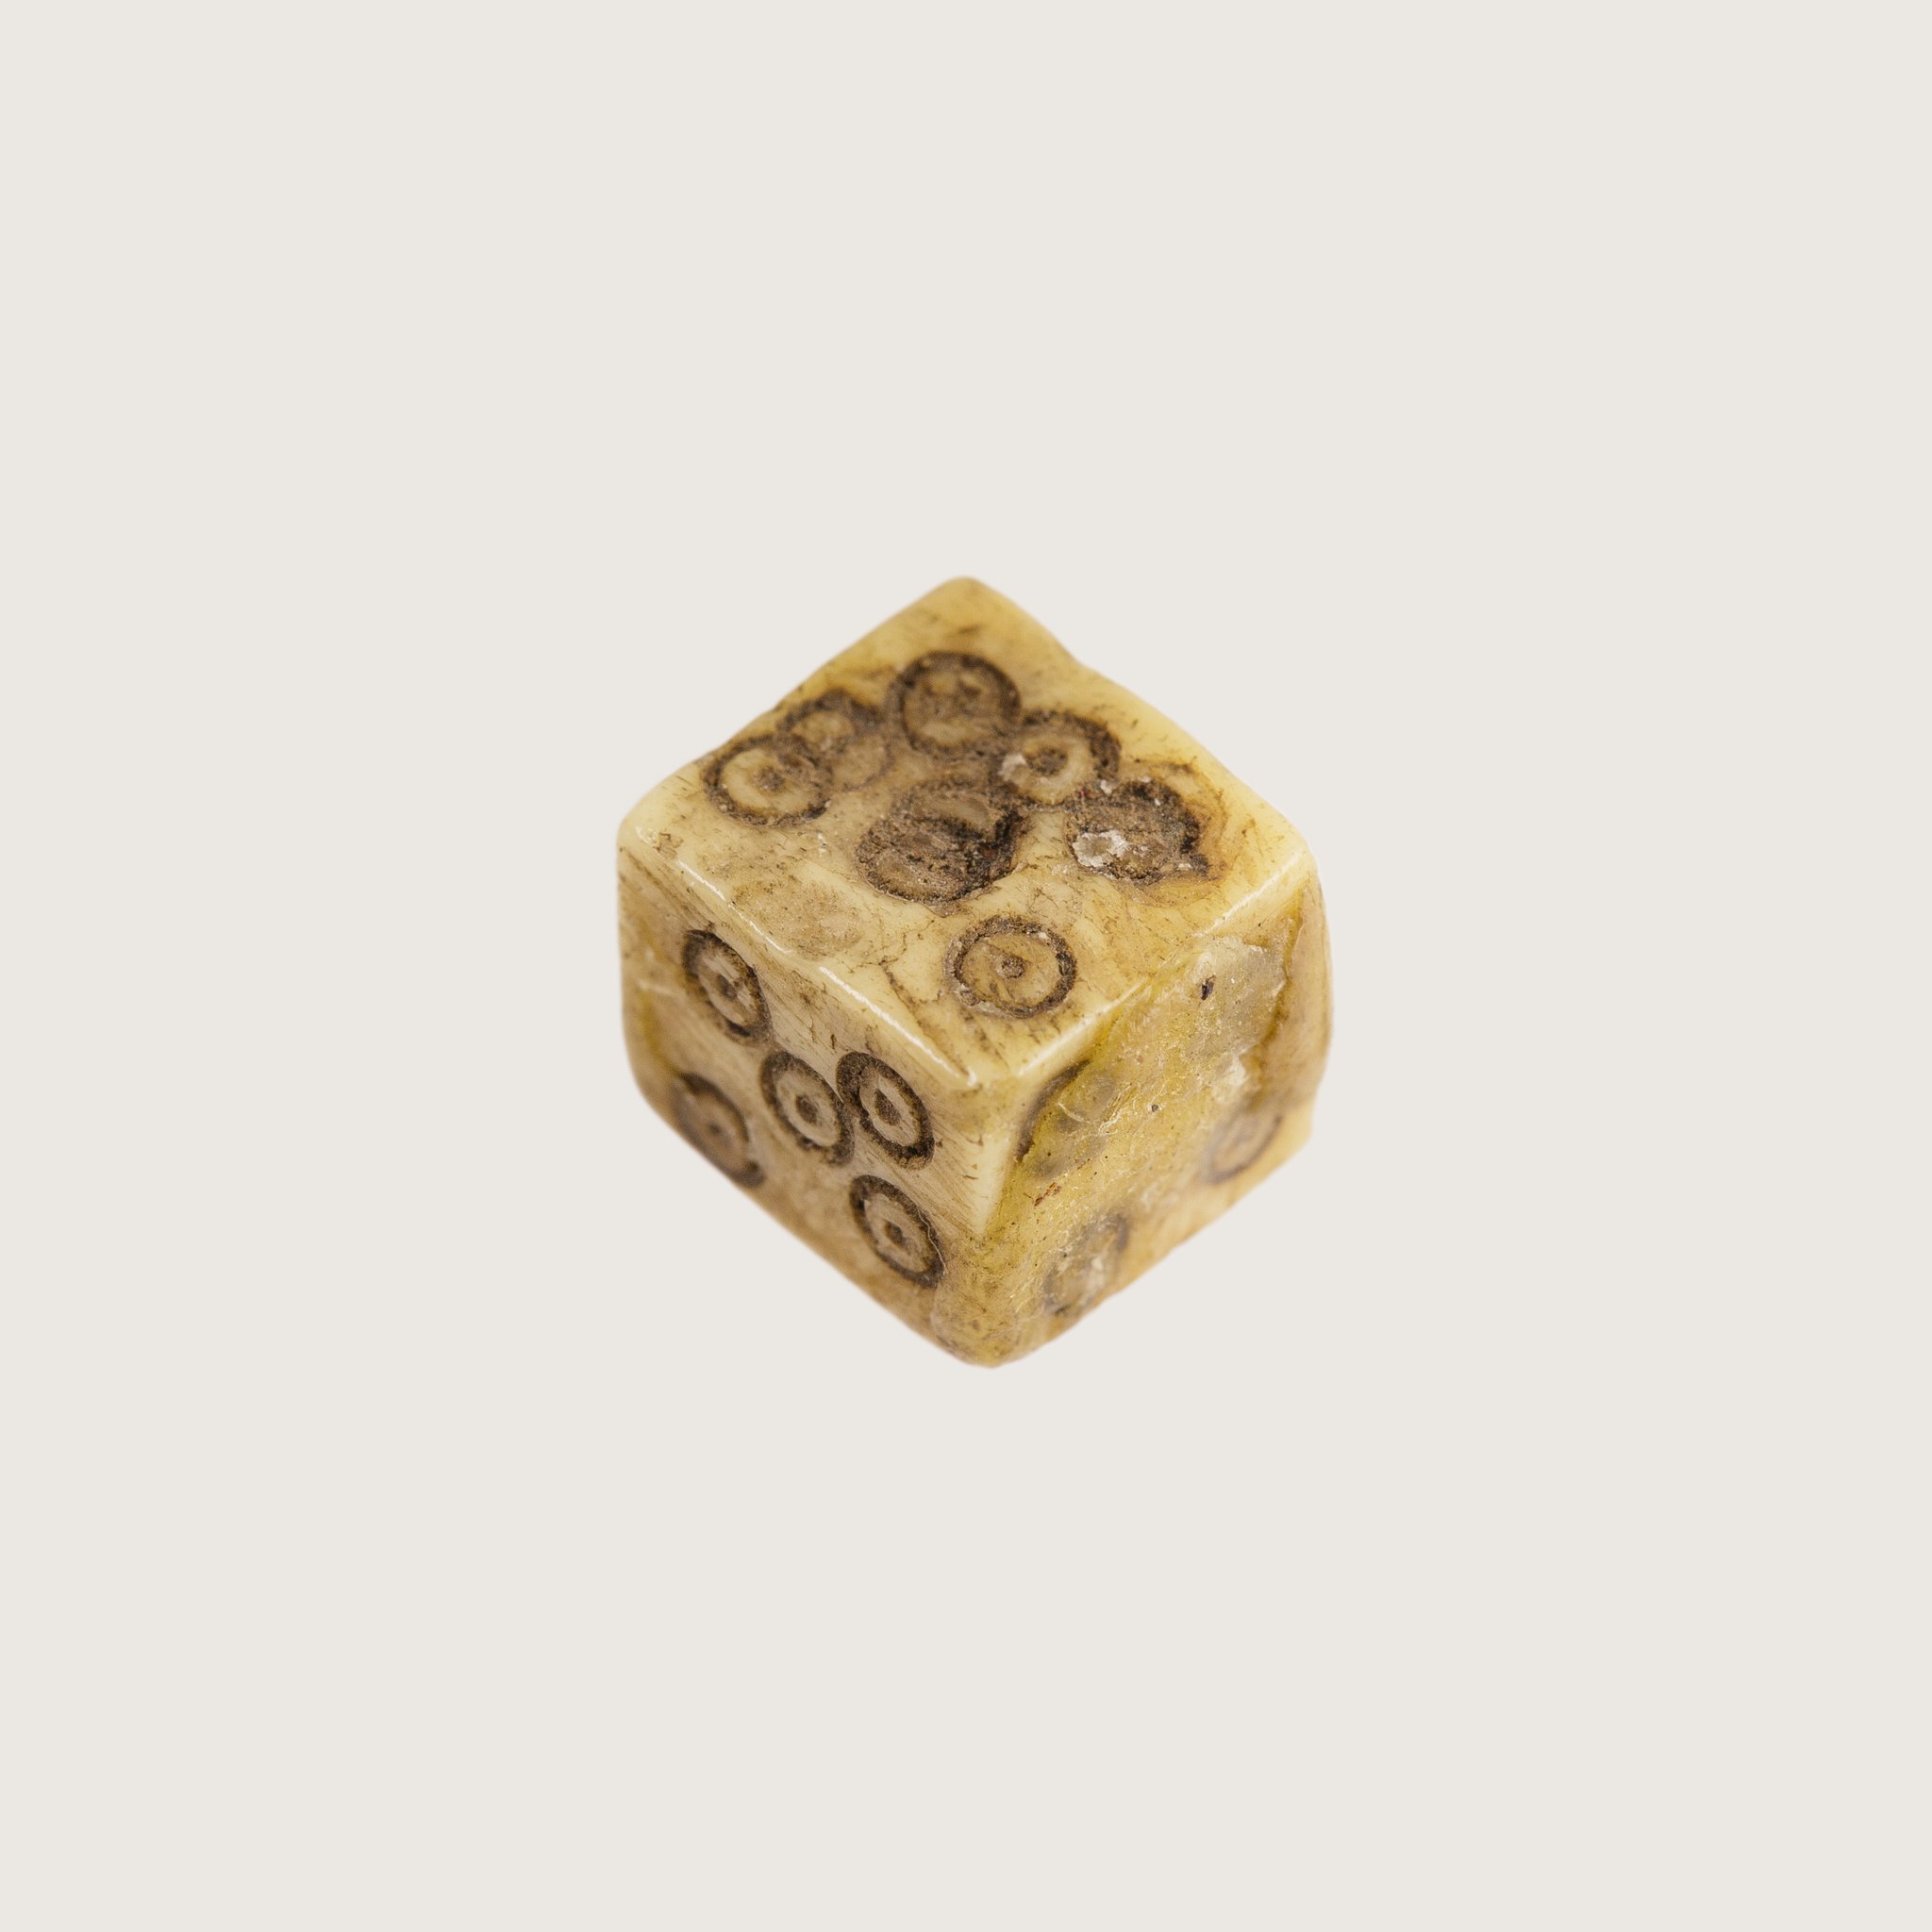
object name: dice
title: Die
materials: ivory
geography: egypt